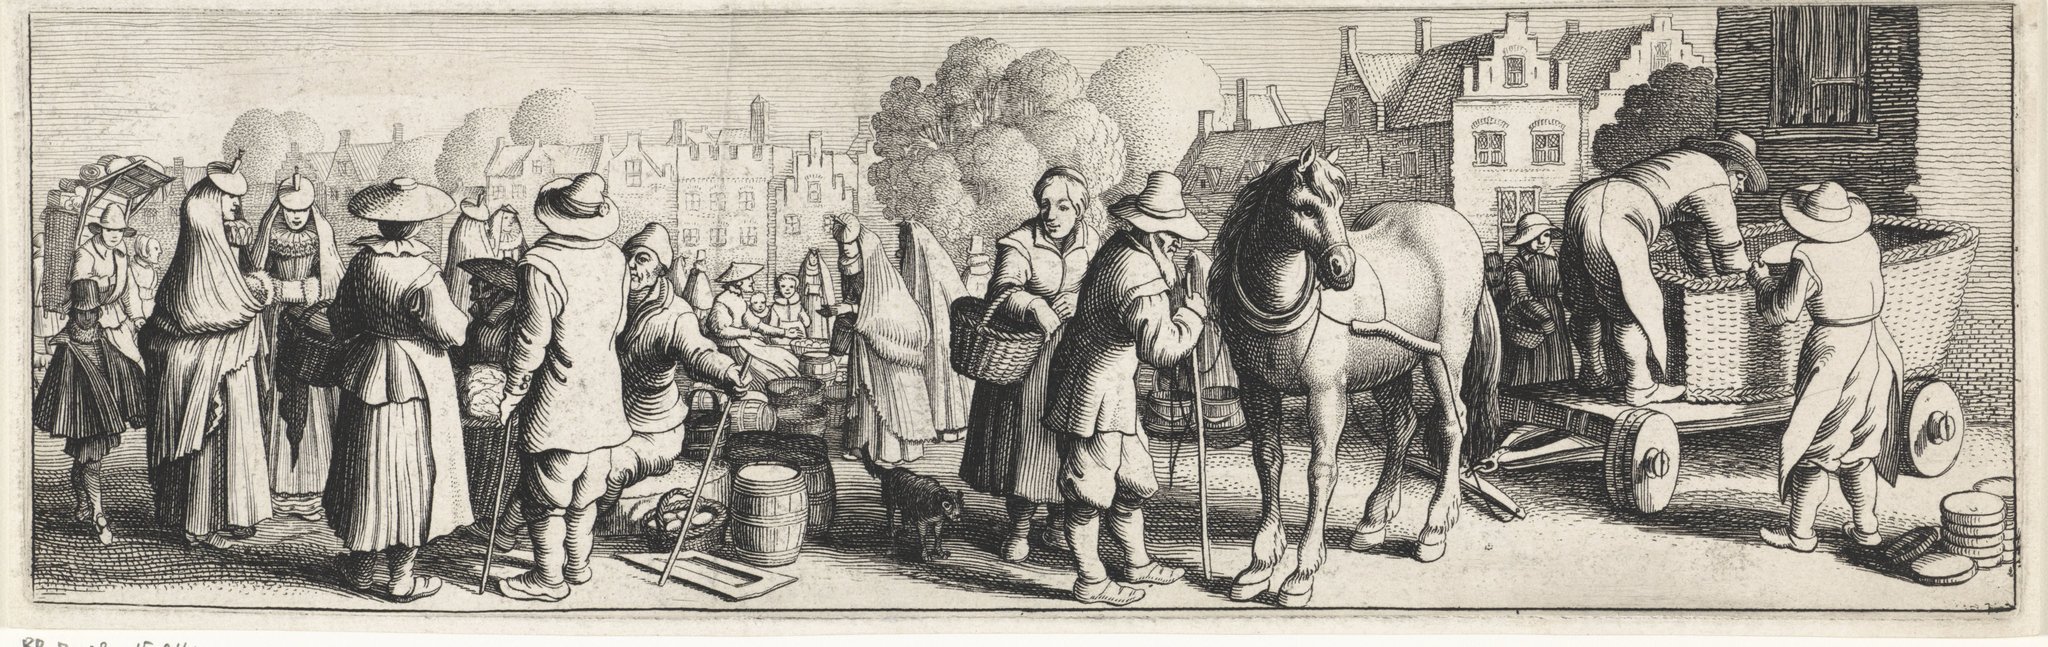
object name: print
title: Markt, serie B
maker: jan van de velde (ii)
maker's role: draughtsman, painter, print maker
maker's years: 1593-1641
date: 1603-1633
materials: paper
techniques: engraving, etching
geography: northern netherlands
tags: clothes, costume (+ children's clothes), cape (huik) (+ women's clothes), head-gear: hat (+ men's clothes), clothes, costume (+ women's clothes), head-gear: hat (+ women's clothes), neck-gear ~ clothing (with name) (+ women's clothes), clothes, costume (+ men's clothes), market, neck-gear: collar (+ men's clothes), (farm) wagon, freight wagon, cart, traffic and transport (+ unloading)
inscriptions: collector's mark: Lugt 240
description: Markttafereel met rechts op de voorgrond een paard voor een kar met rieten mand erop. De mand wordt uitgeladen door twee mannen. Op de achtergrond huizen. Vierde prent van een fries bestaande uit vier prenten, voorstellende een markt.